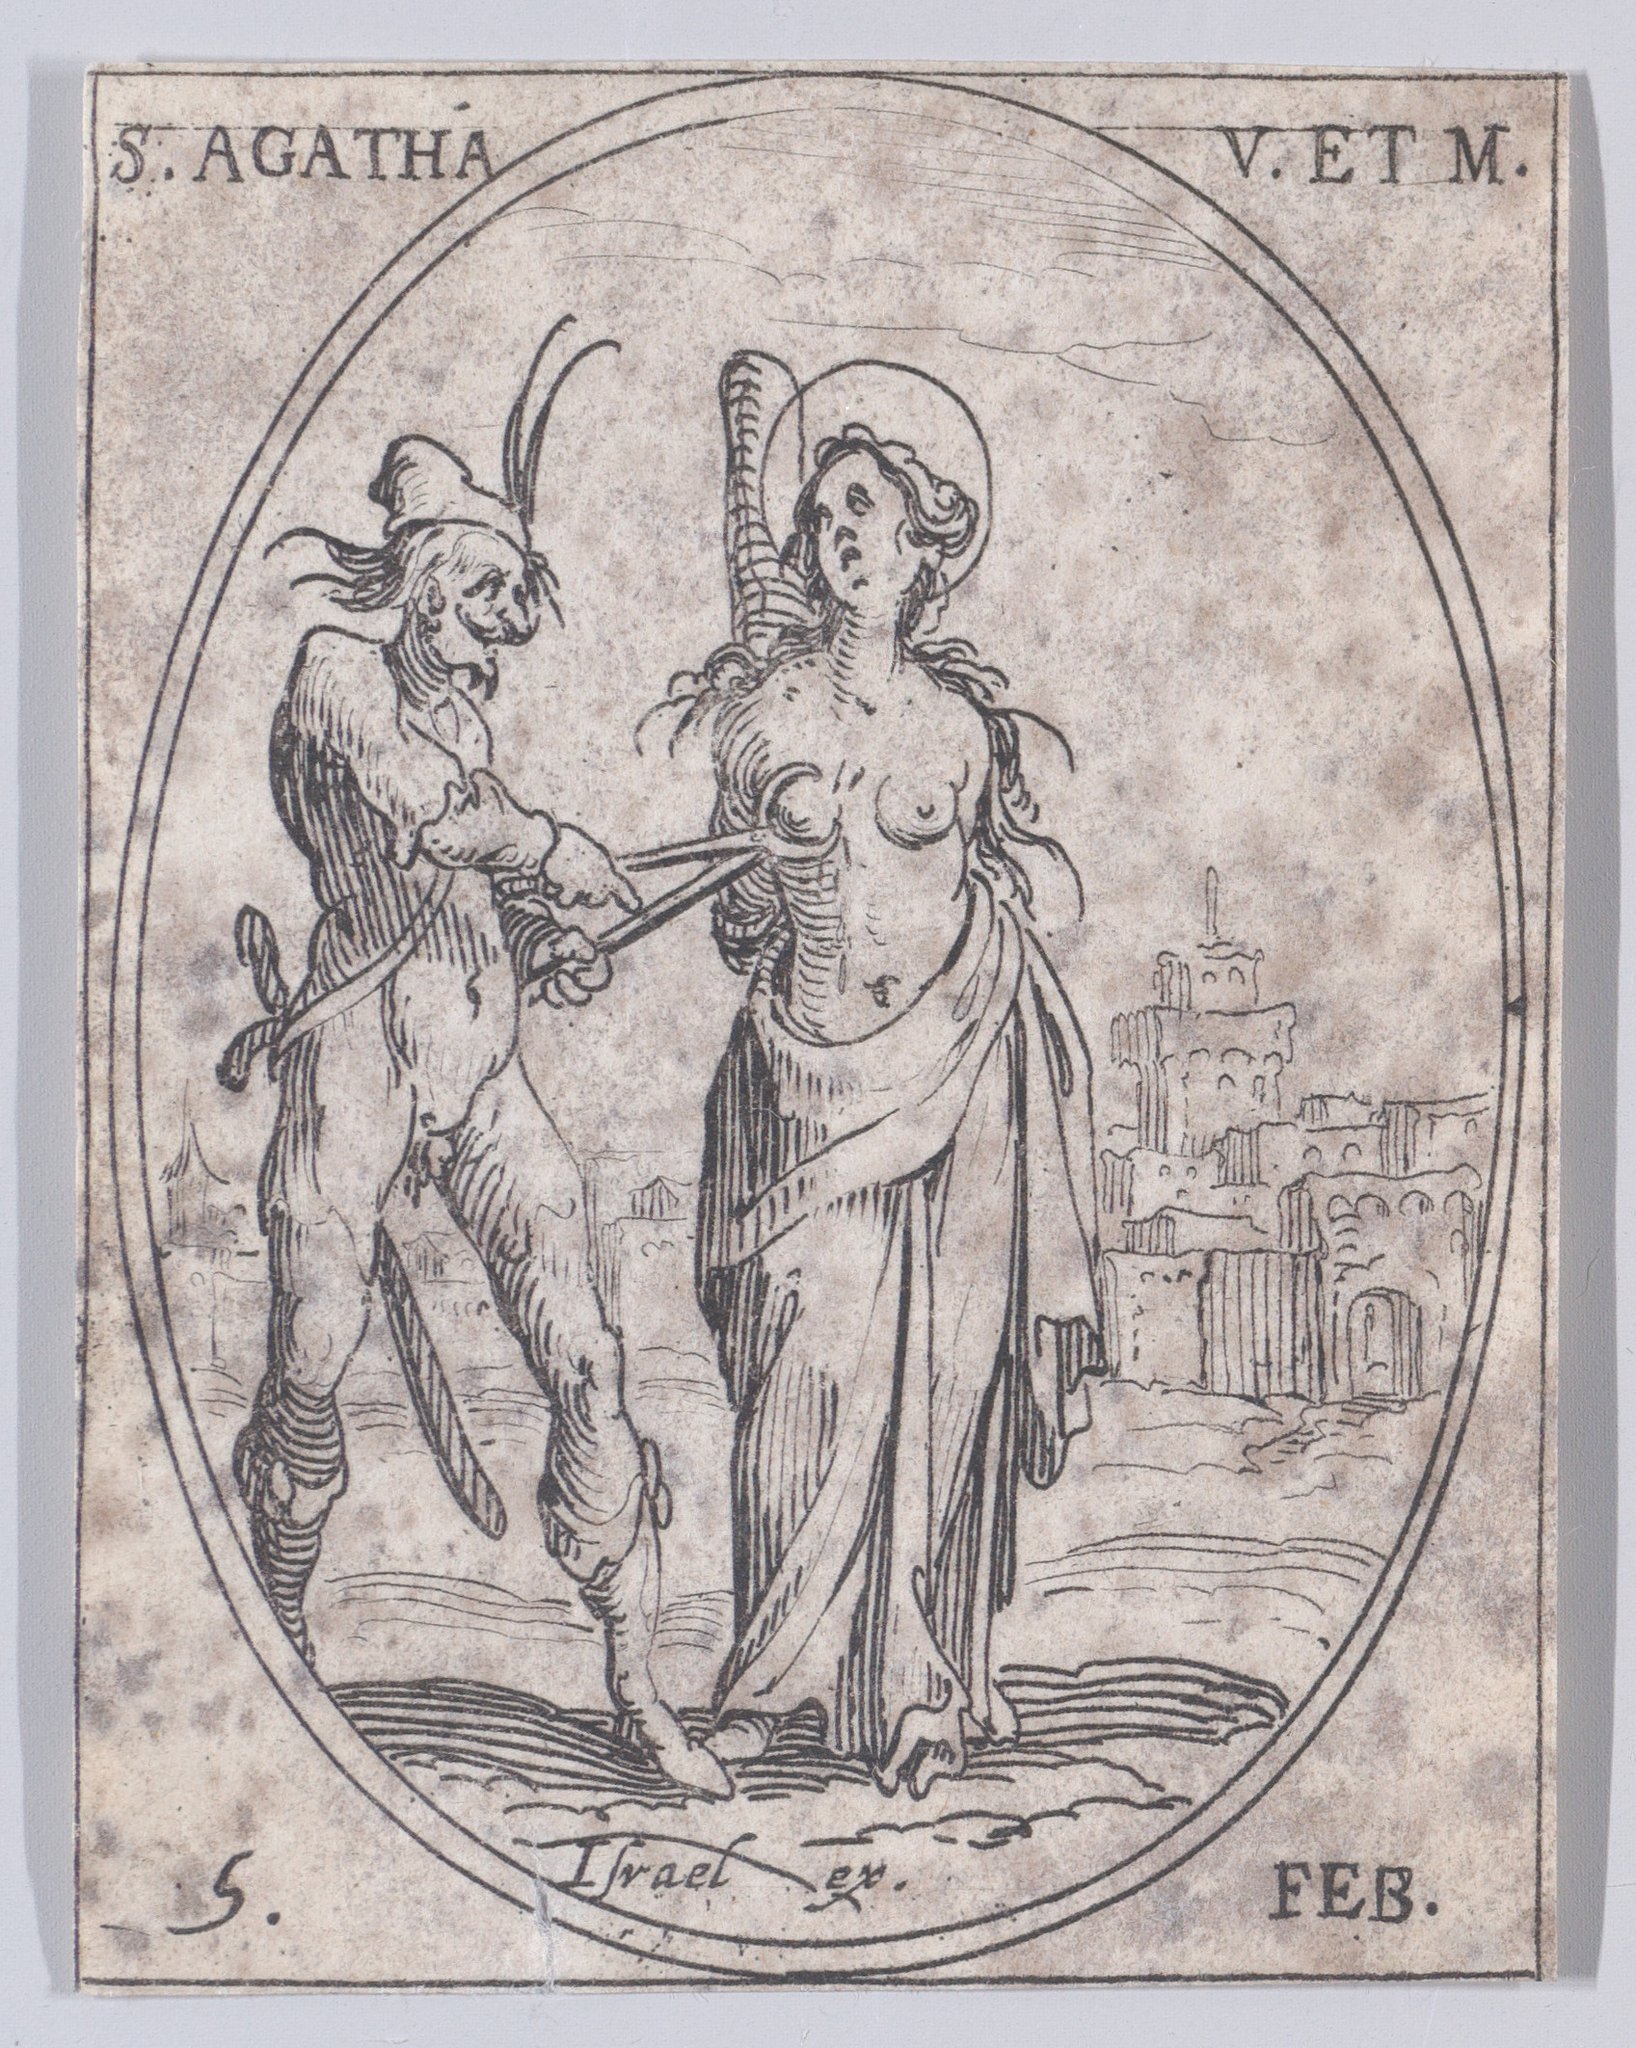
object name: print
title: Ste. Agathe, vierge et martyre (St. Agatha, Virgin and Martyr), February 5th, from "Les Images De Tous Les Saincts et Saintes de L'Année" (Images of All of the Saints and Feast Days of the Year)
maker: jacques callot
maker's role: artist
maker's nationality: french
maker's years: 1592-1635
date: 1636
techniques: etching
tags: women,saints